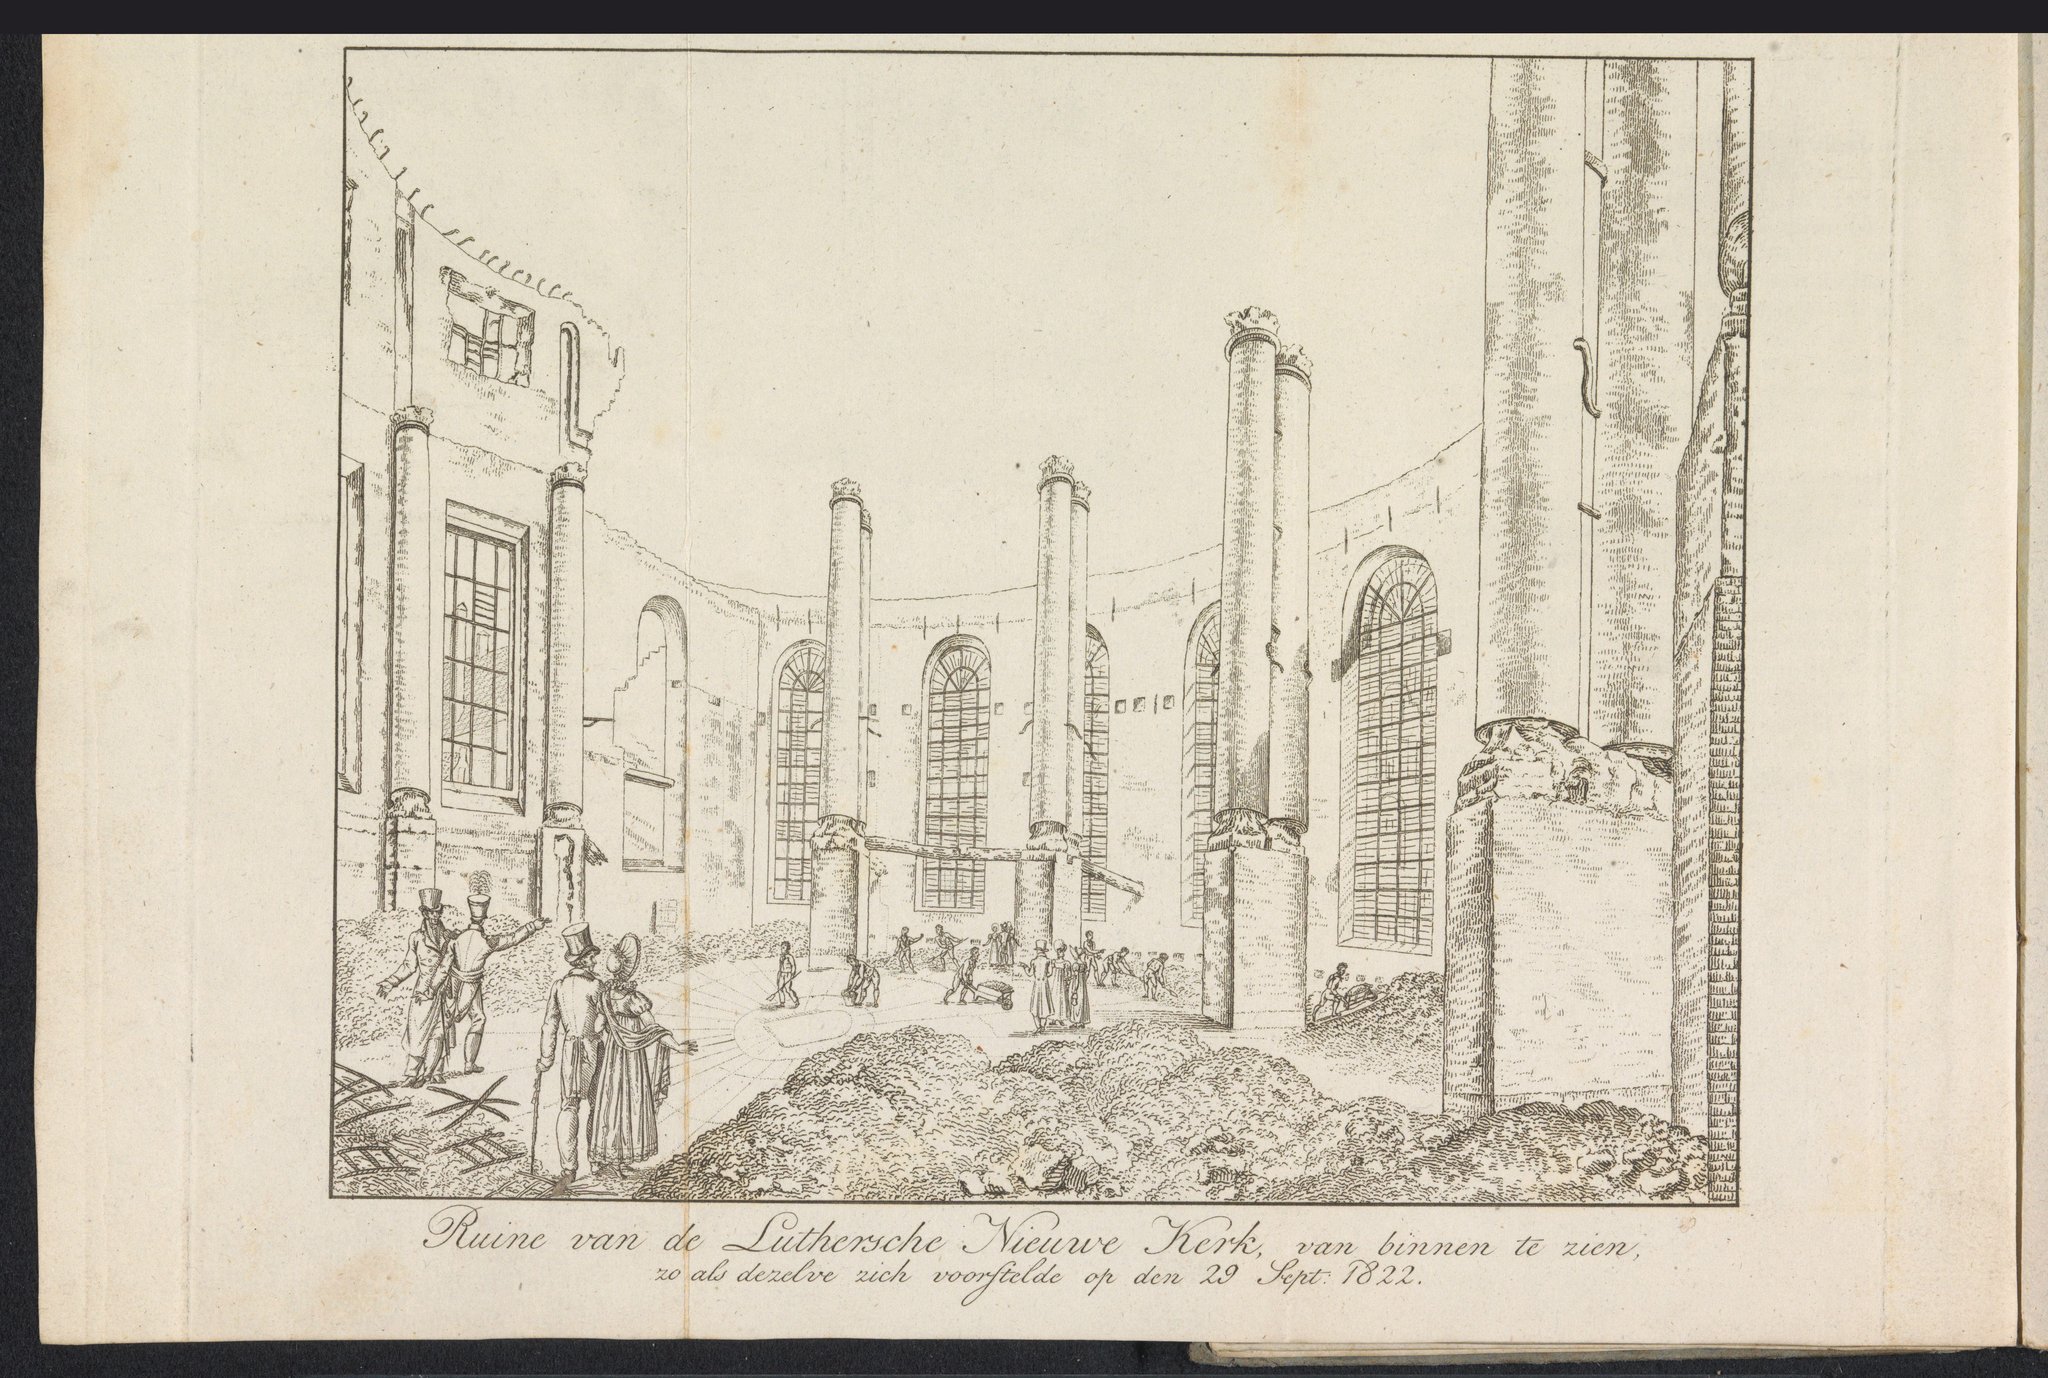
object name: print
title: Ruine van de Luthersche Nieuwe Kerk, van binnen te zien, zo als dezelve zich voorstelde op den 29 Sept. 1822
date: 1822-1823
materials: paper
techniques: etching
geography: amsterdam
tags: on fire, ablaze, ruin of a building ~ architecture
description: Ruïne van de Nieuwe Lutherse Kerk op het Singel te Amsterdam, na de brand op 18 september 1822. Interieur van de kerk zoals deze zich vertoonde op 29 september 1822. Illustratie in een uitgave uit 1823 over de brand.